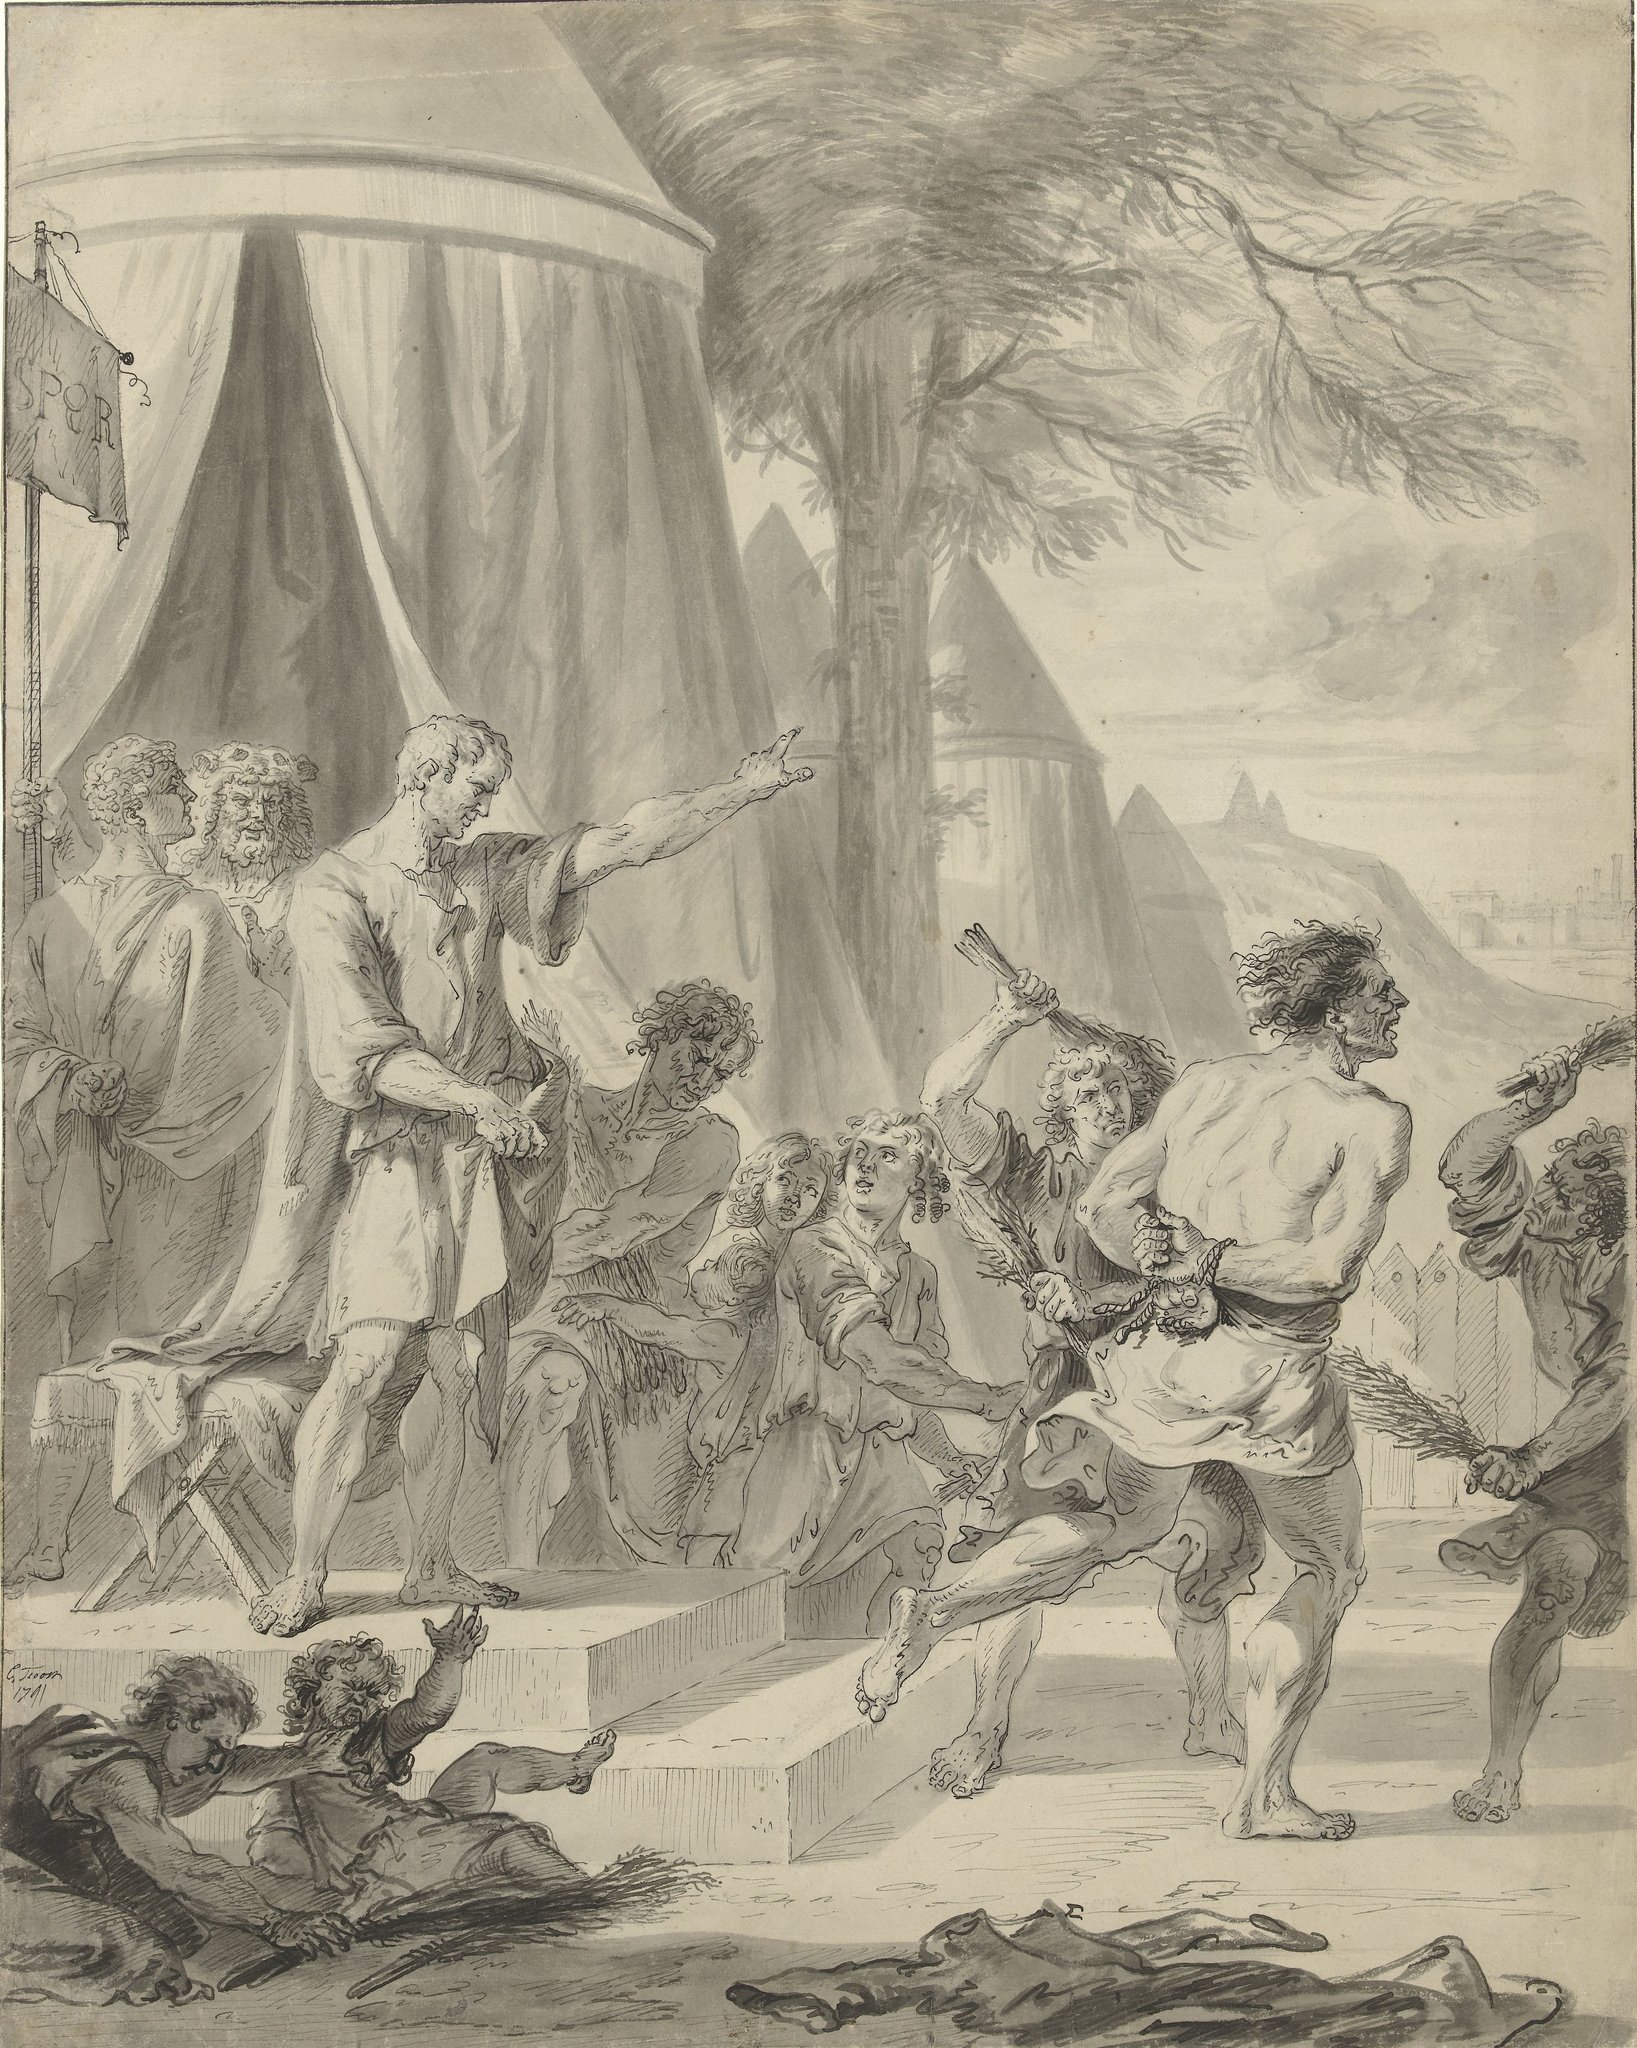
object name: drawing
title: Marcus Furius Camillus laat de schoolmeester van de Falerii door diens leerlingen geselen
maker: cornelis troost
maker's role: draughtsman, painter, print maker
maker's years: 1696-1750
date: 1741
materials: ink, paper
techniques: brush, pen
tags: elementary school; class, form (+ teacher, professor), marcus furius camillus has the schoolmaster of falerii chastised by his pupils: he is stripped and the children drive him back to their city with sticks